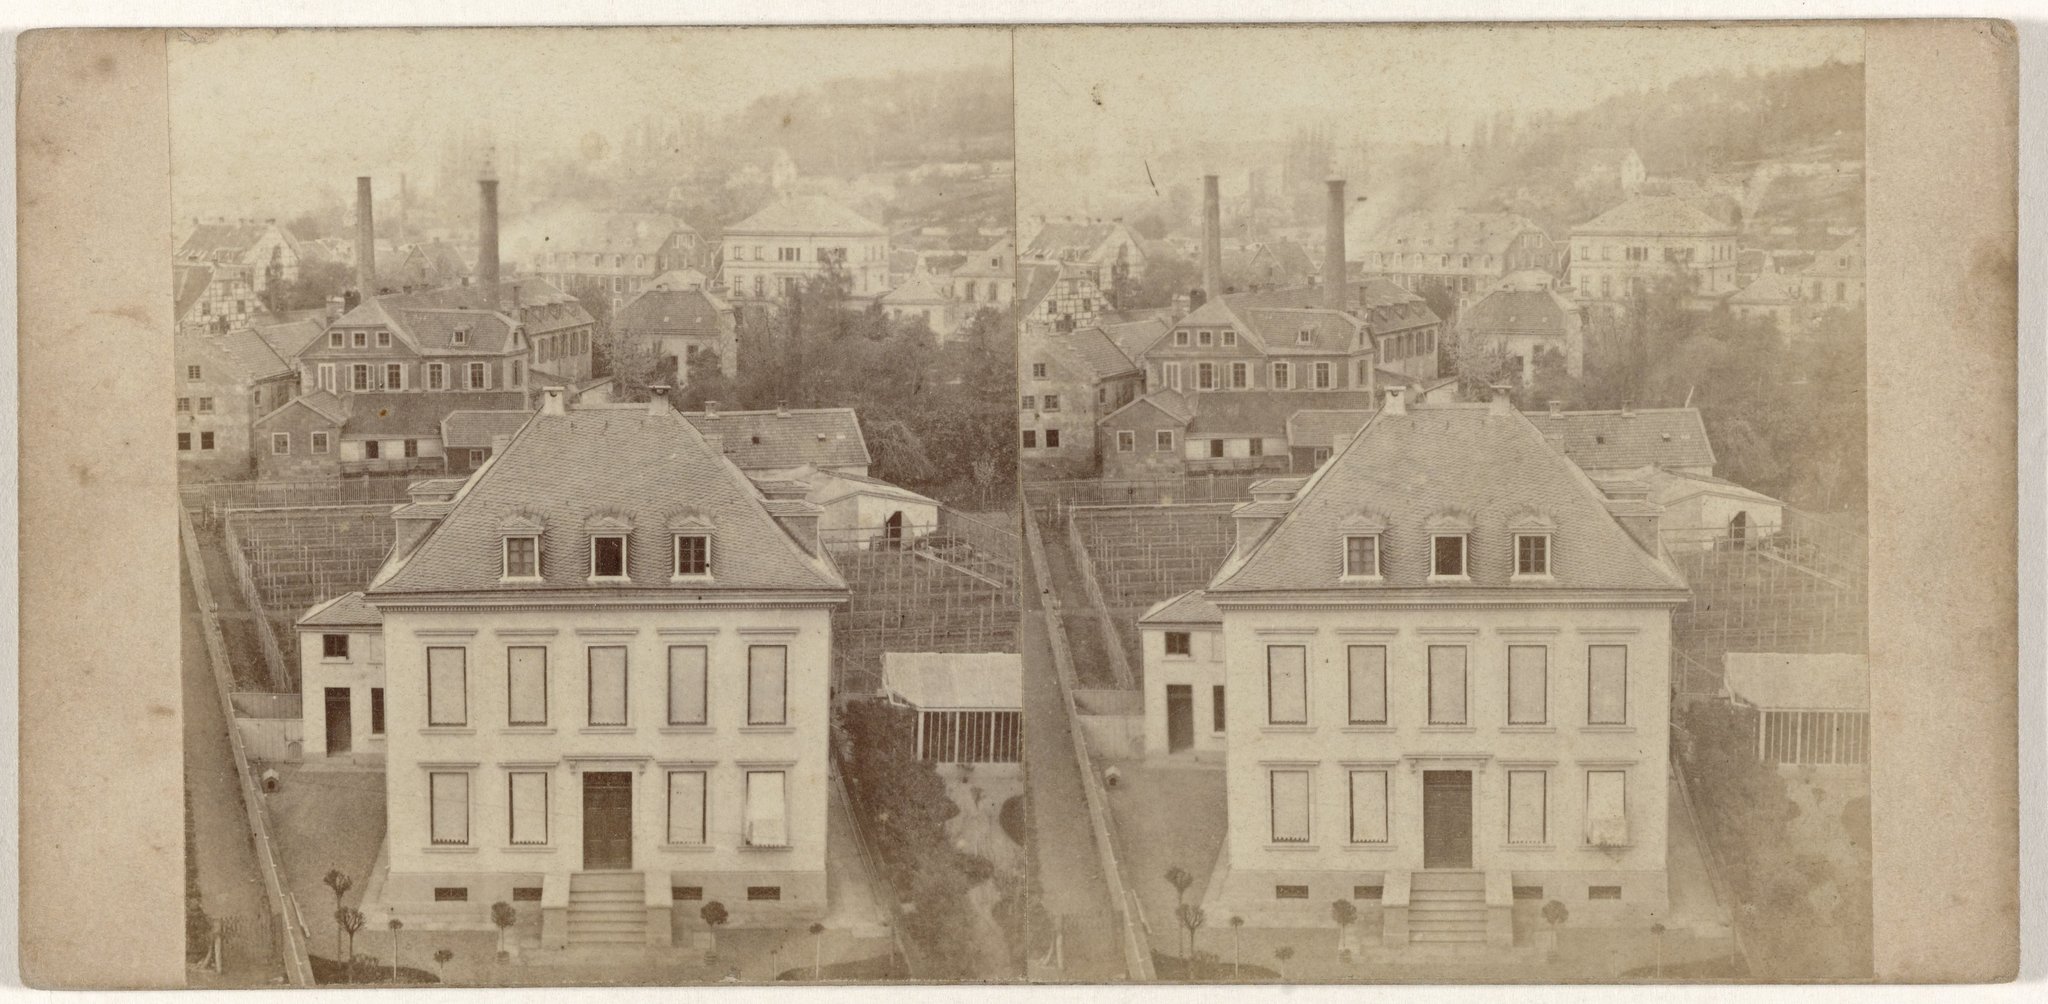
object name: stereograph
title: Gezicht op Kleef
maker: Anonymous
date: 1852-1863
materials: cardboard, paper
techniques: albumen print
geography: cleves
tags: city-view in general; 'veduta', façade (of house or building), cleves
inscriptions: inscription: ‘Cleve, 3/6’, inscription: ‘[...]’, inscription: ‘F. Boys’, number: ‘No. 57.’